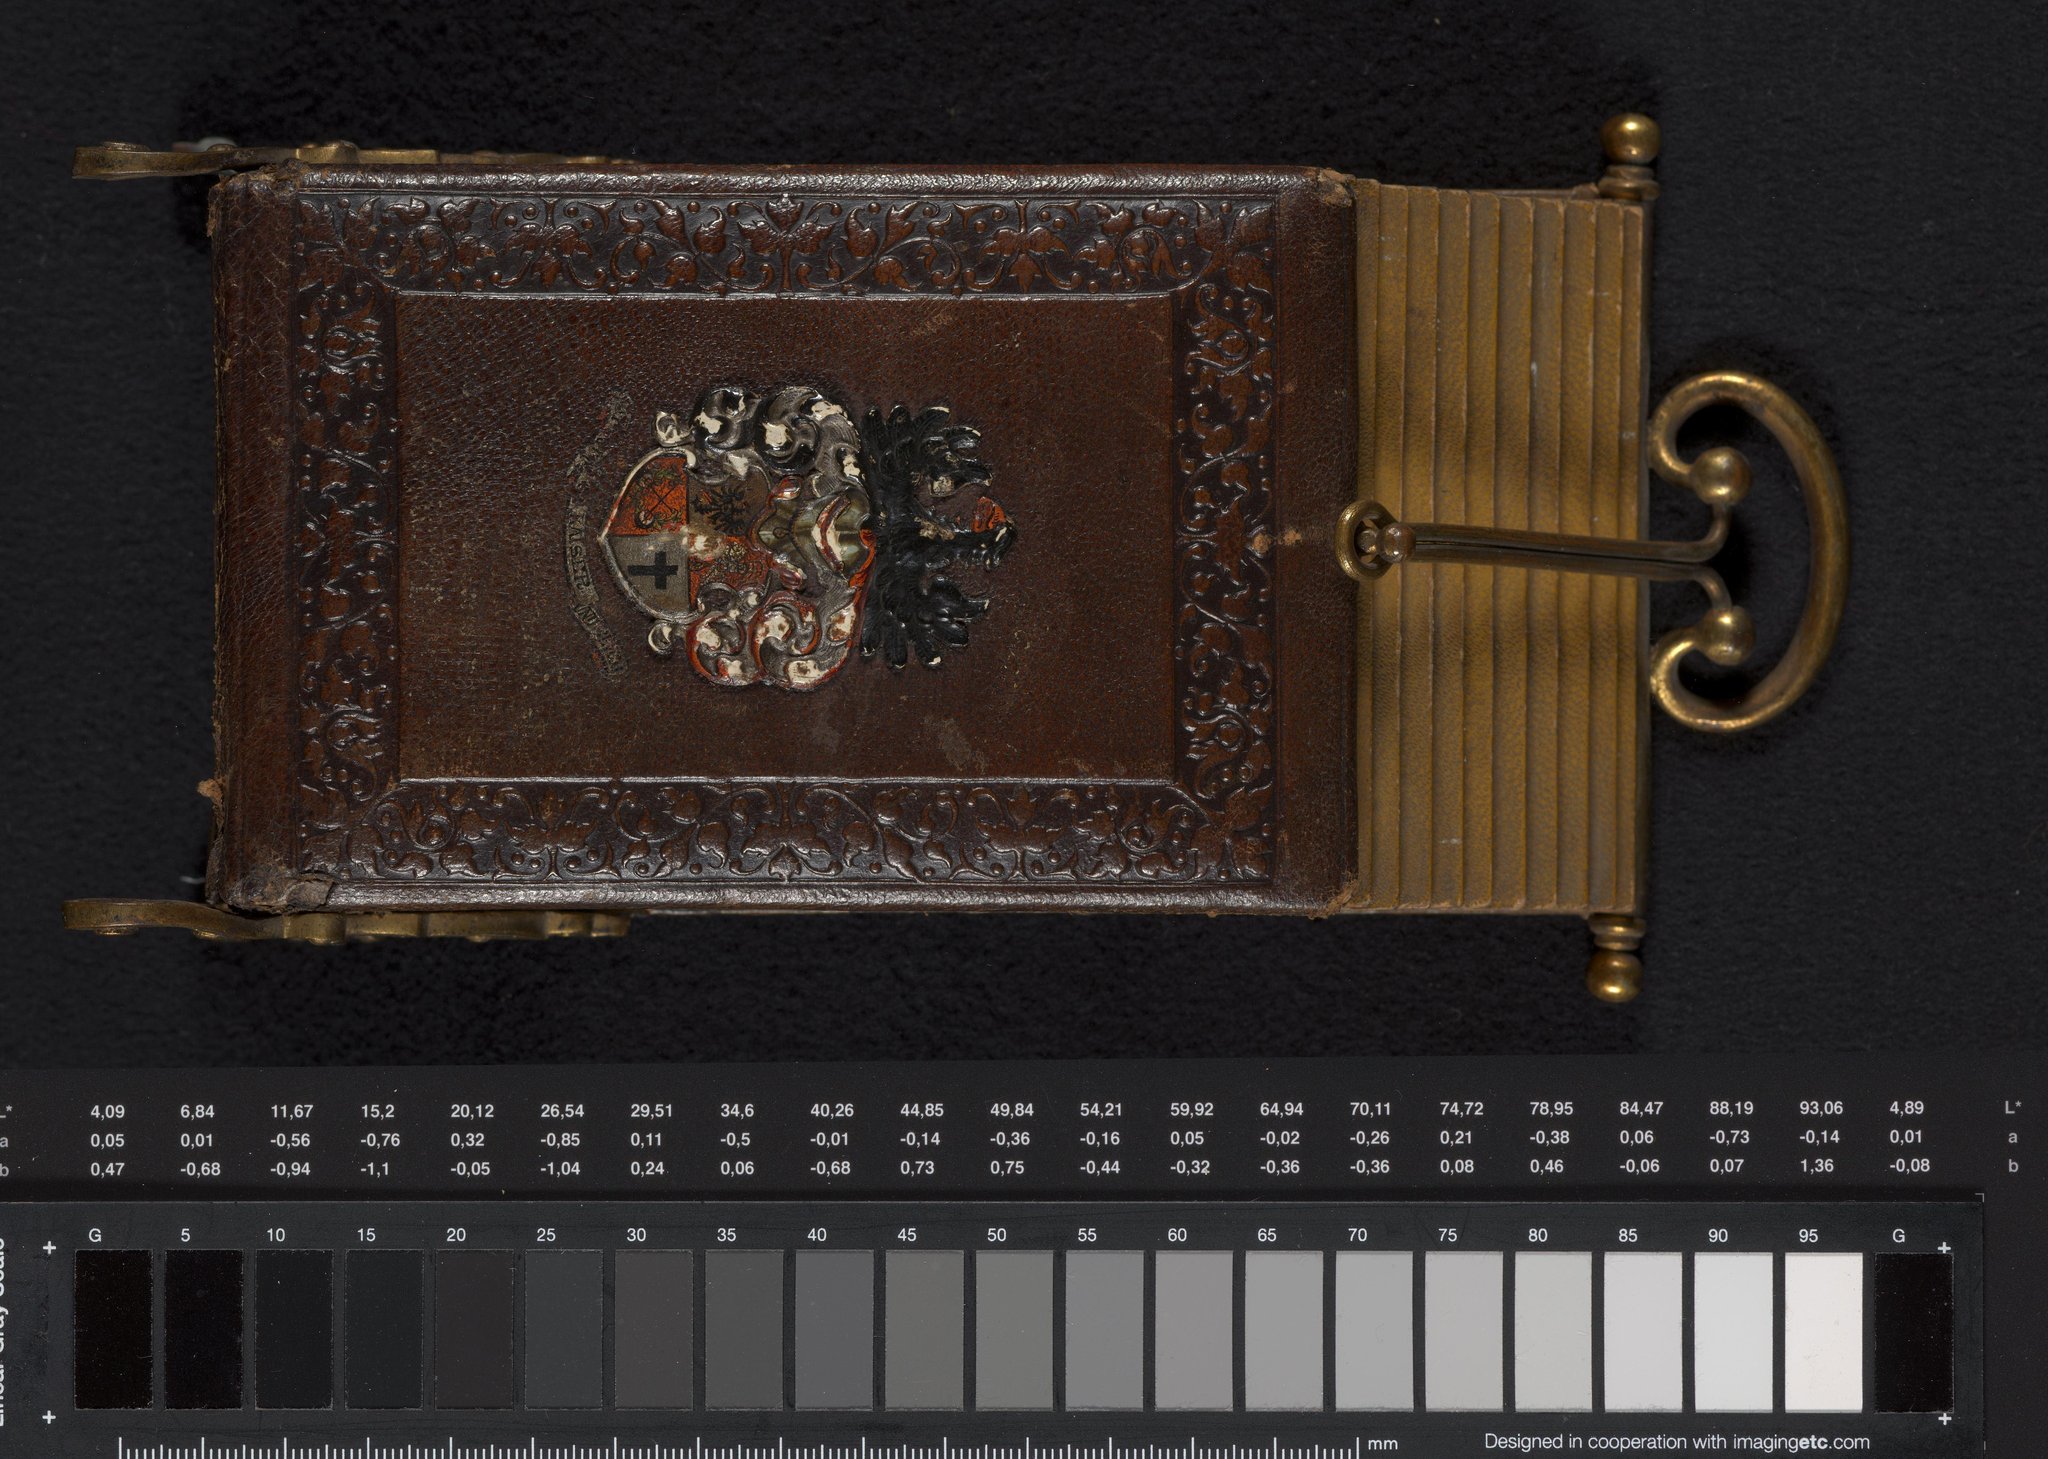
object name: slip in album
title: Duits familiealbum met elf foto's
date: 1896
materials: cardboard, metal, paper, photographic support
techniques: albumen print, decorated paper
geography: germany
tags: moustache, historical persons, youth, adolescent, (military) uniforms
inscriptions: collector's mark: ‘DIENST/ VERSPREIDE/ RIJKSKOLLEKTIES/ (...) A 1226’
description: Fotoalbum met 11 cartes-de-visite op 22 pagina's. De passe-partout aan de voorzijde van ieder albumblad is gevuld met een carte-de-visite. Afgebeeld zijn portretten van mannen. De foto's zijn gemaakt door de Duitse fotografen Alfred Naumann, Carl Wilhelm, Atelier Billström, Zieger & Turrigy, Alex Putzar, Otto Damm en Eduard Glaubach. Van 1 foto is de naam van de vervaardiger niet geheel leesbaar.